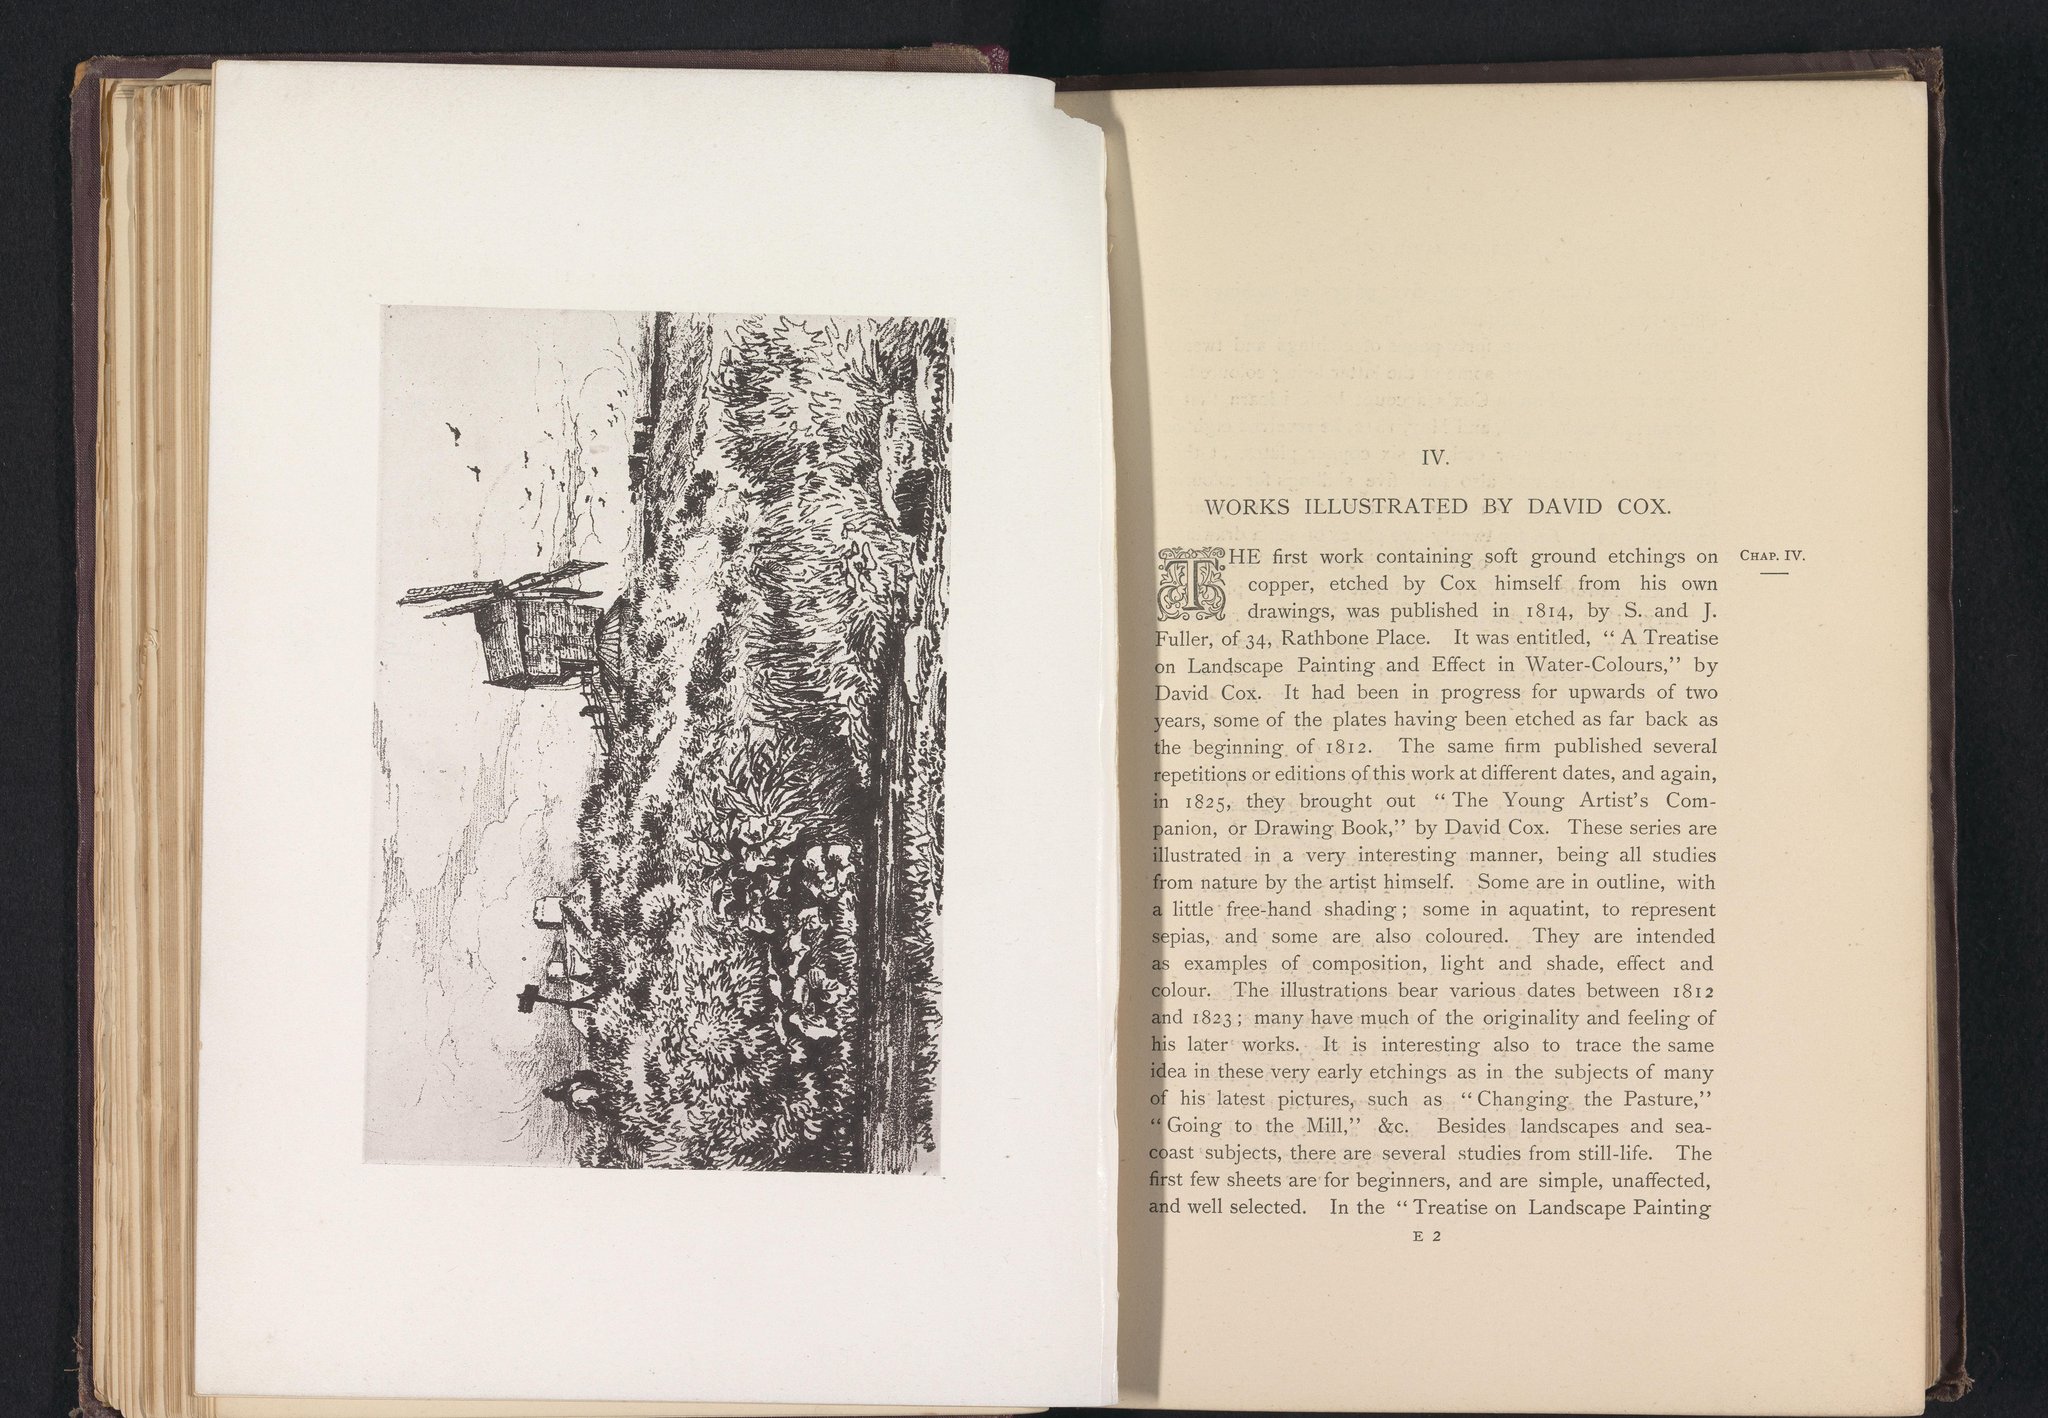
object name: reproduction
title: Fotoreproductie van een ets van een molen bij Mosley Common door David Cox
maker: Anonymous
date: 1863-1873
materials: paper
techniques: photoaquatint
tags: print, e.g.: engraving, etching, lithograph, windmill in landscape